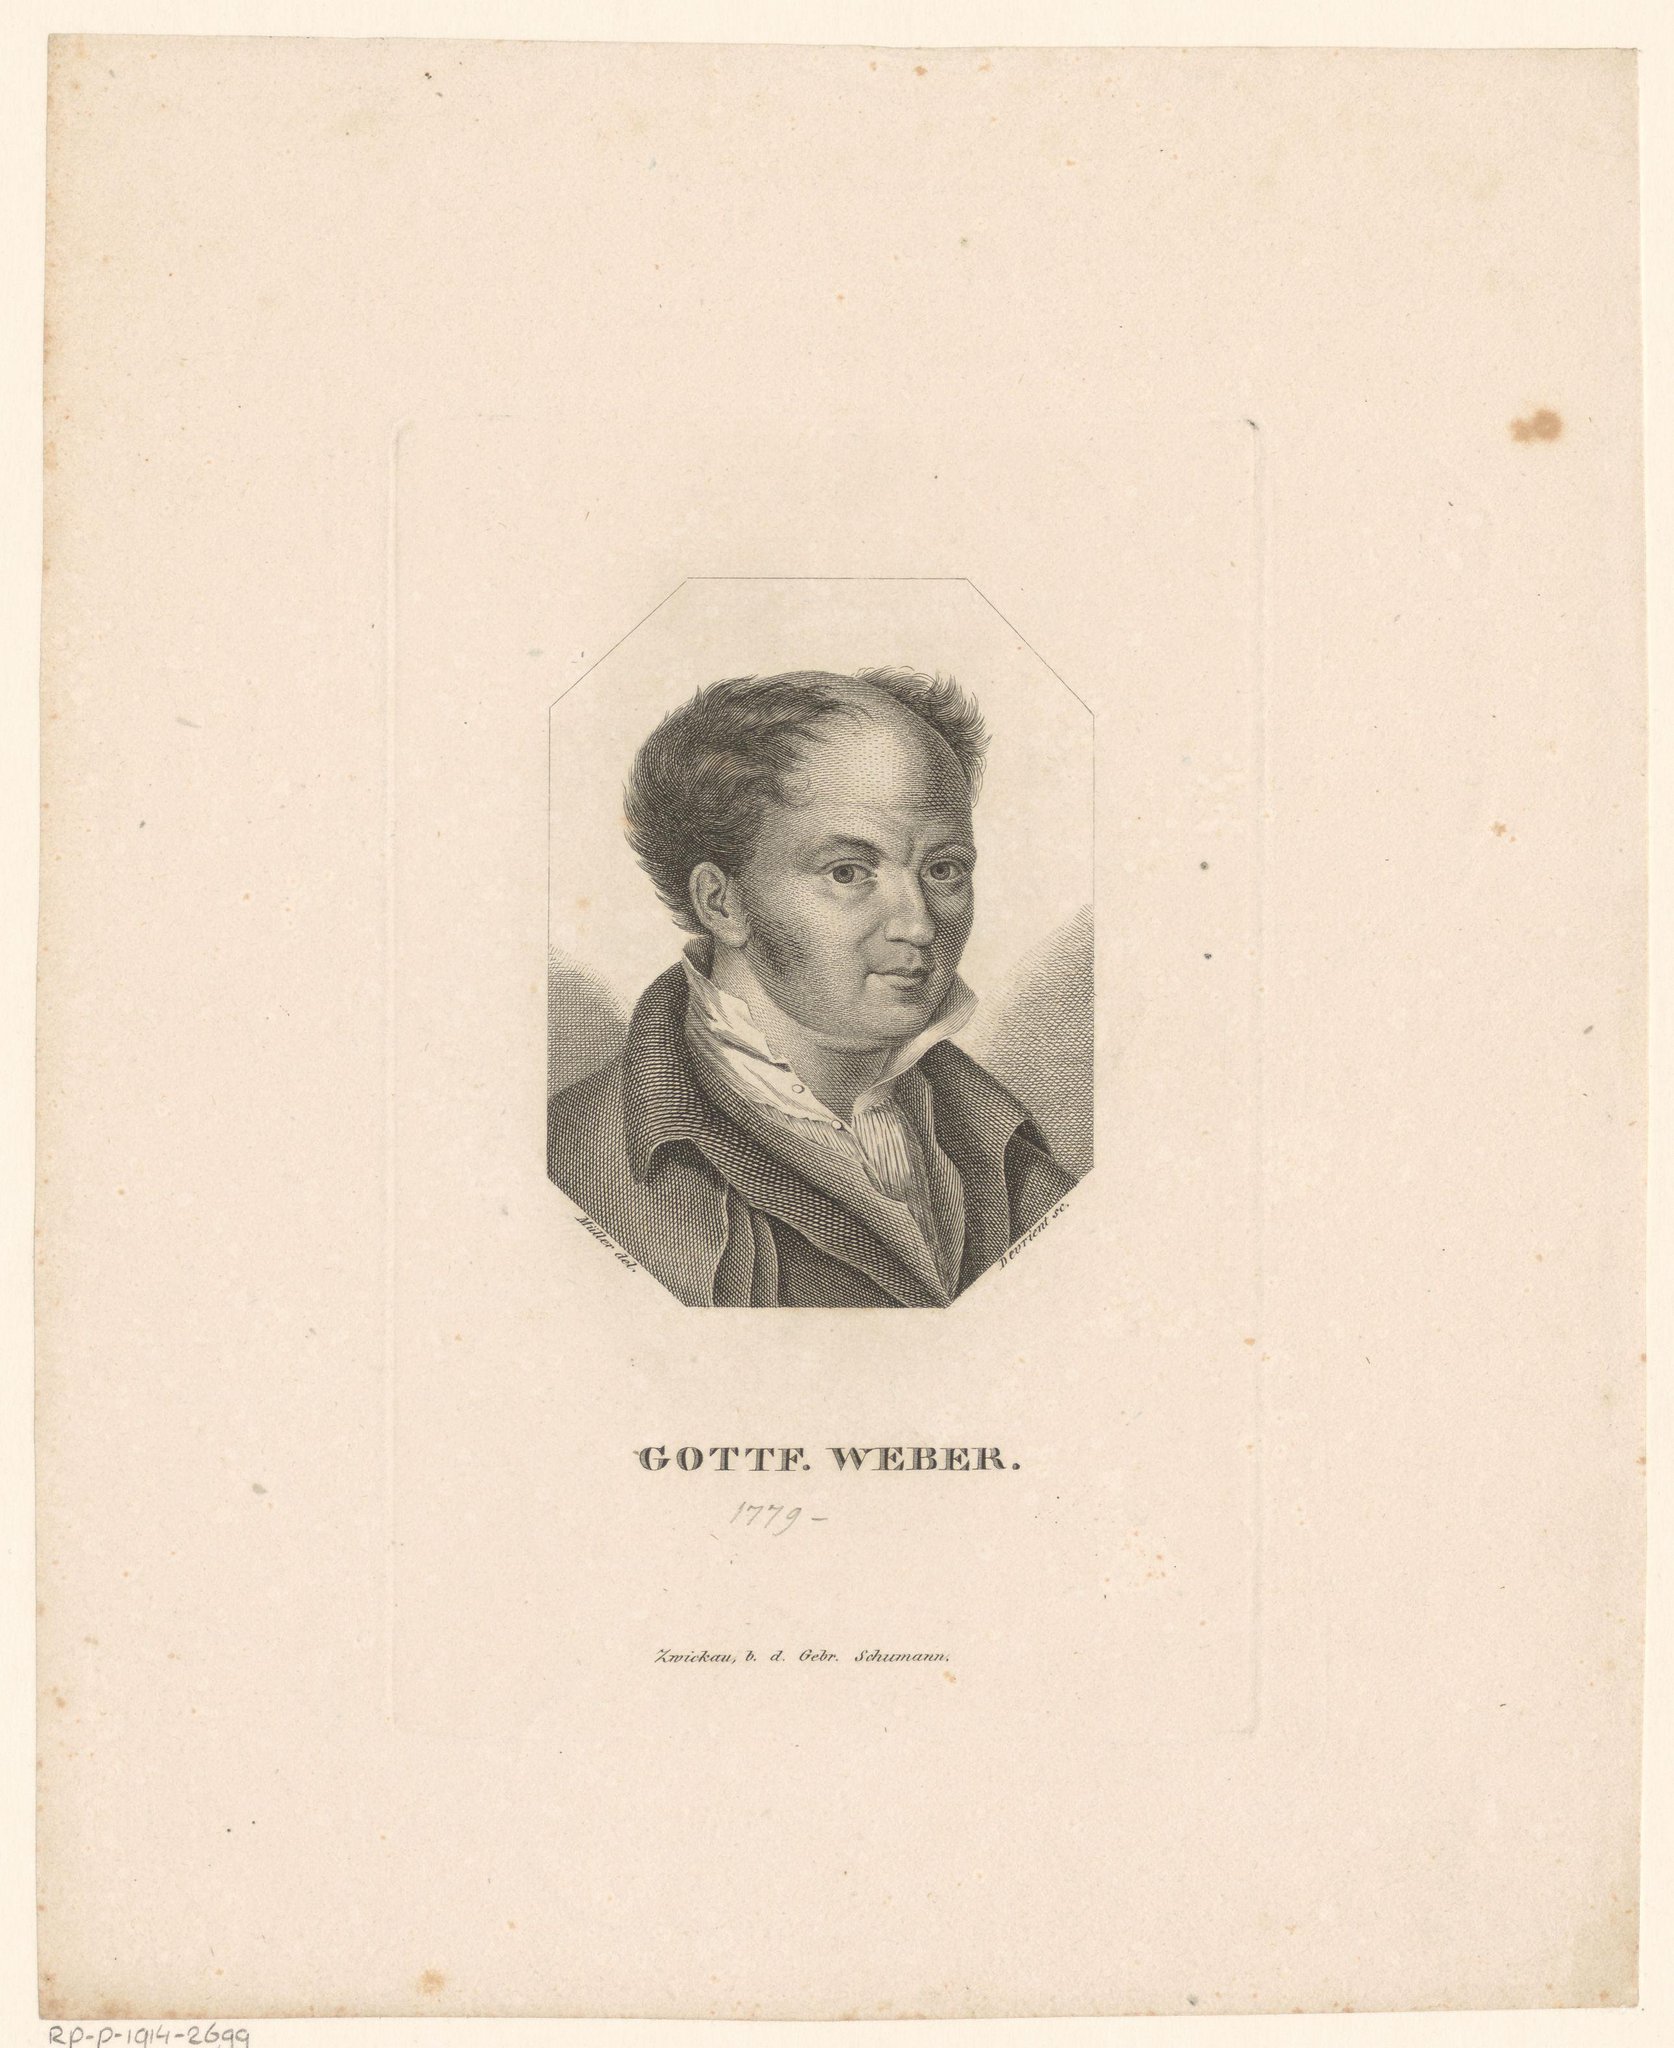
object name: print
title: Bildnisse der berühmtesten Menschen aller Völker und Zeiten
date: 1818-1832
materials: paper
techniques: engraving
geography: germany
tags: historical persons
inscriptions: collector's mark: Lugt 2228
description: Prent afkomstig uit: 'Bildnisse der berühmtesten Menschen aller Völker und Zeiten' van de gebroeders Schumann, uitgegeven in 1818-1832 te Zwickau.